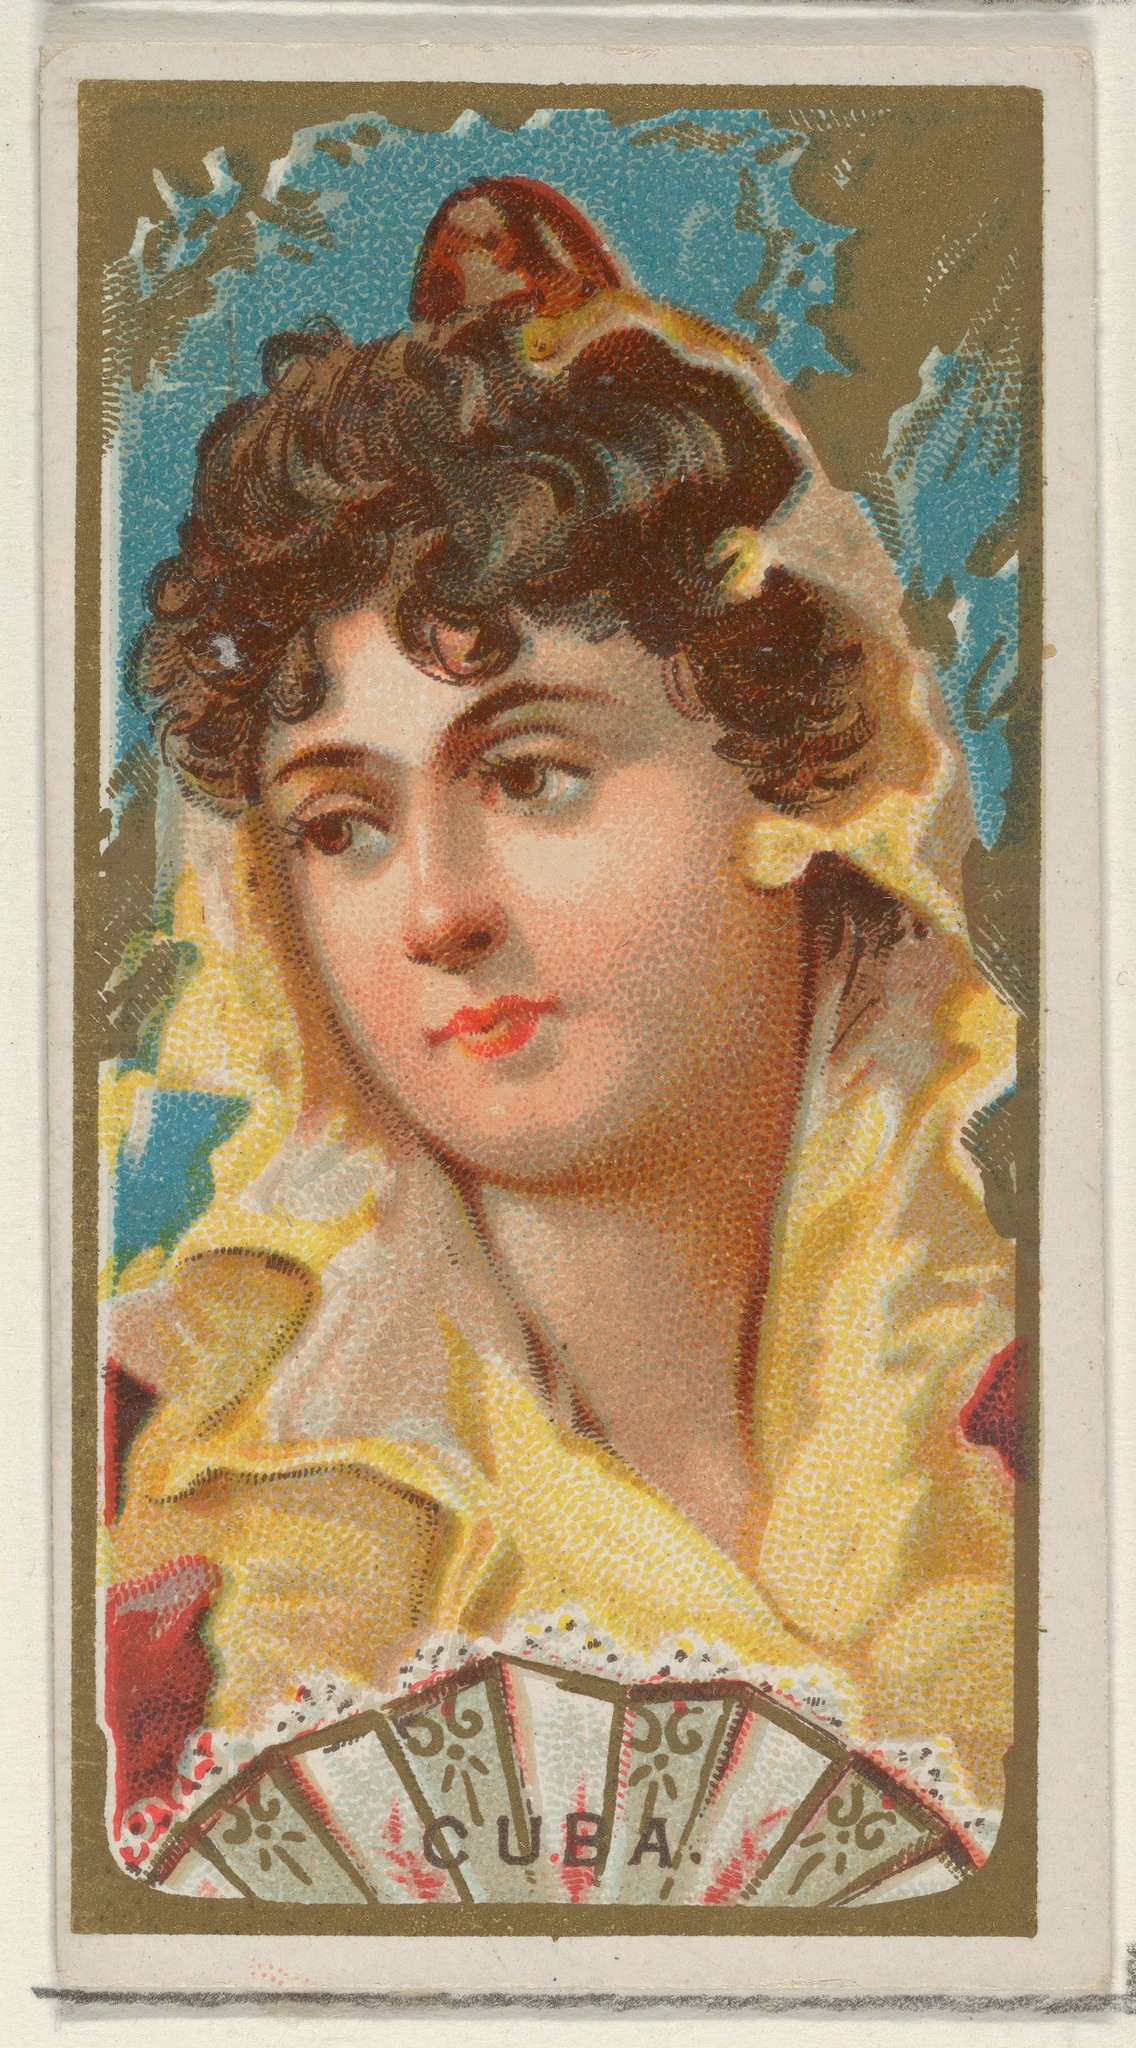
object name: print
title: Cuba, from the Types of All Nations series (N24) for Allen & Ginter Cigarettes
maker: allen & ginter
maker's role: publisher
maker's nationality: american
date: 1889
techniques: color lithograph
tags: women